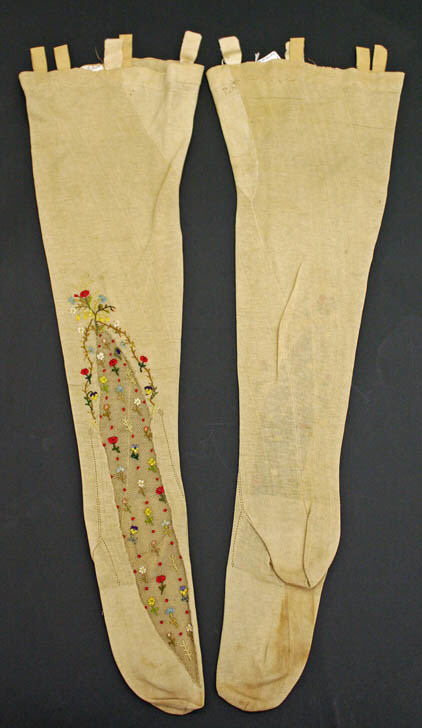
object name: stocking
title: Stockings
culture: french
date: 1801-1900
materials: cotton, silk